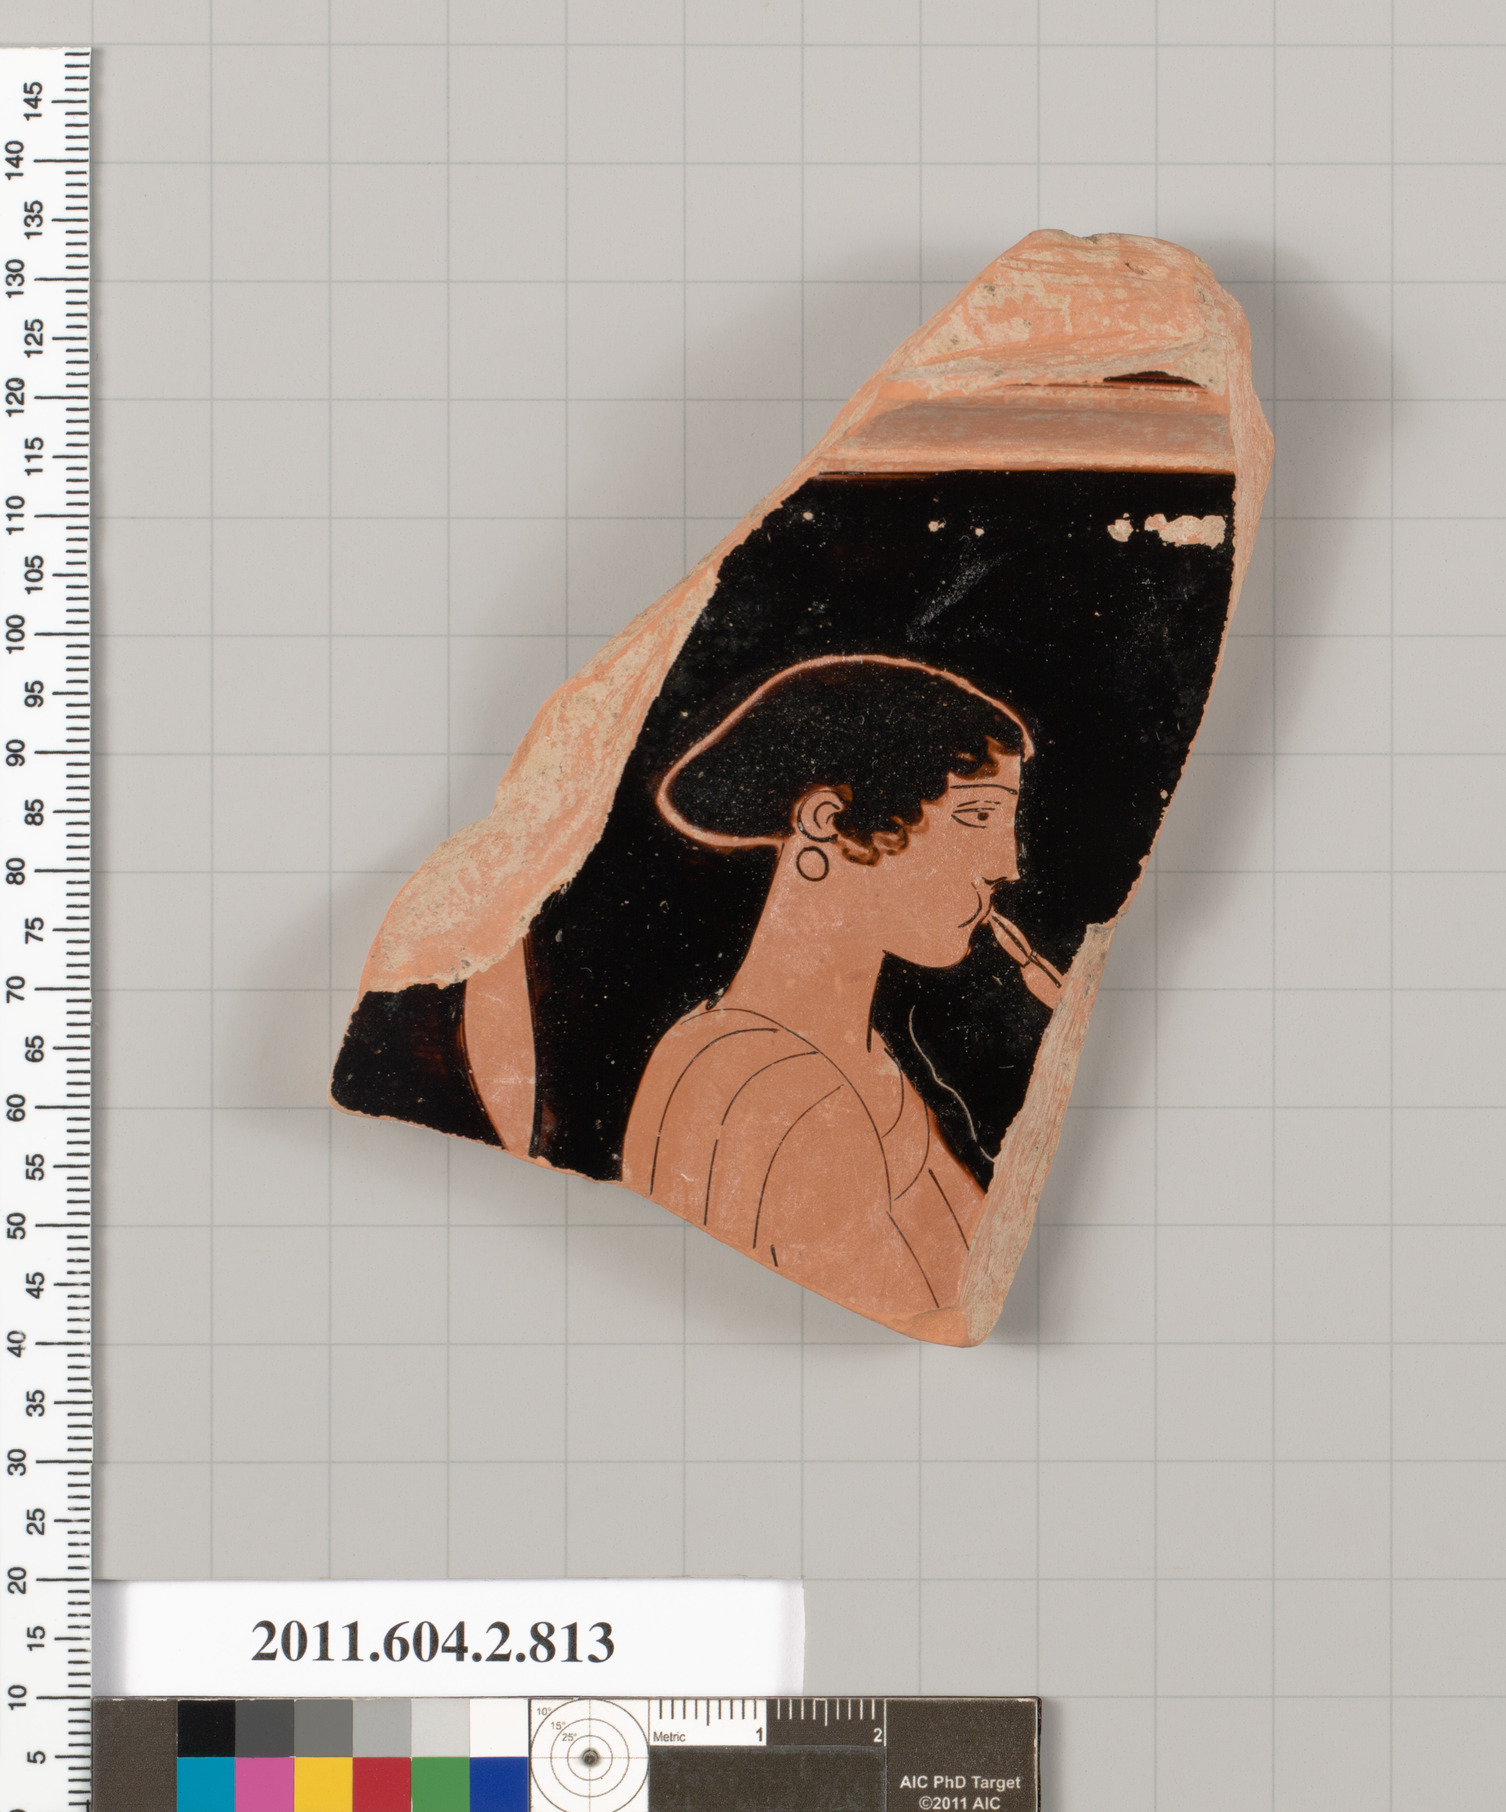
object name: bell krater fragment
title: Terracotta fragment of a bell-krater (bowl for mixing wine and water)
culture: greek, attic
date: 470-450 BCE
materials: terracotta